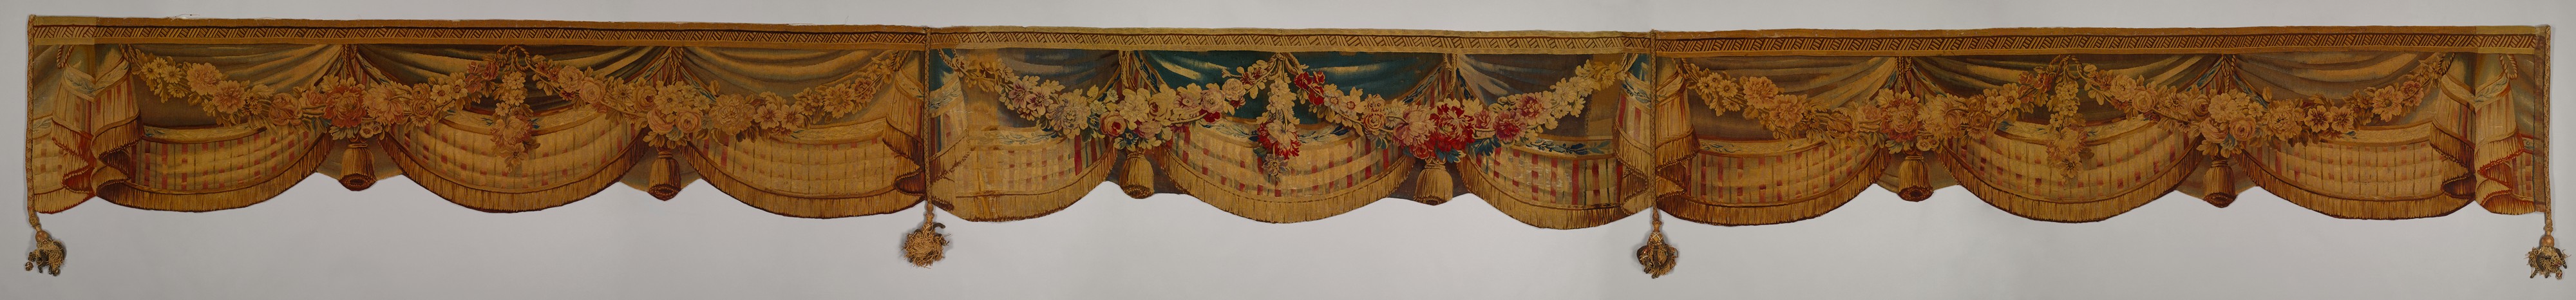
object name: bed valance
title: Valence for a bed (Lit à la duchesse en impériale)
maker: beauvais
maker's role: factory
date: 1780-1790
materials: silk, wool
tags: garlands